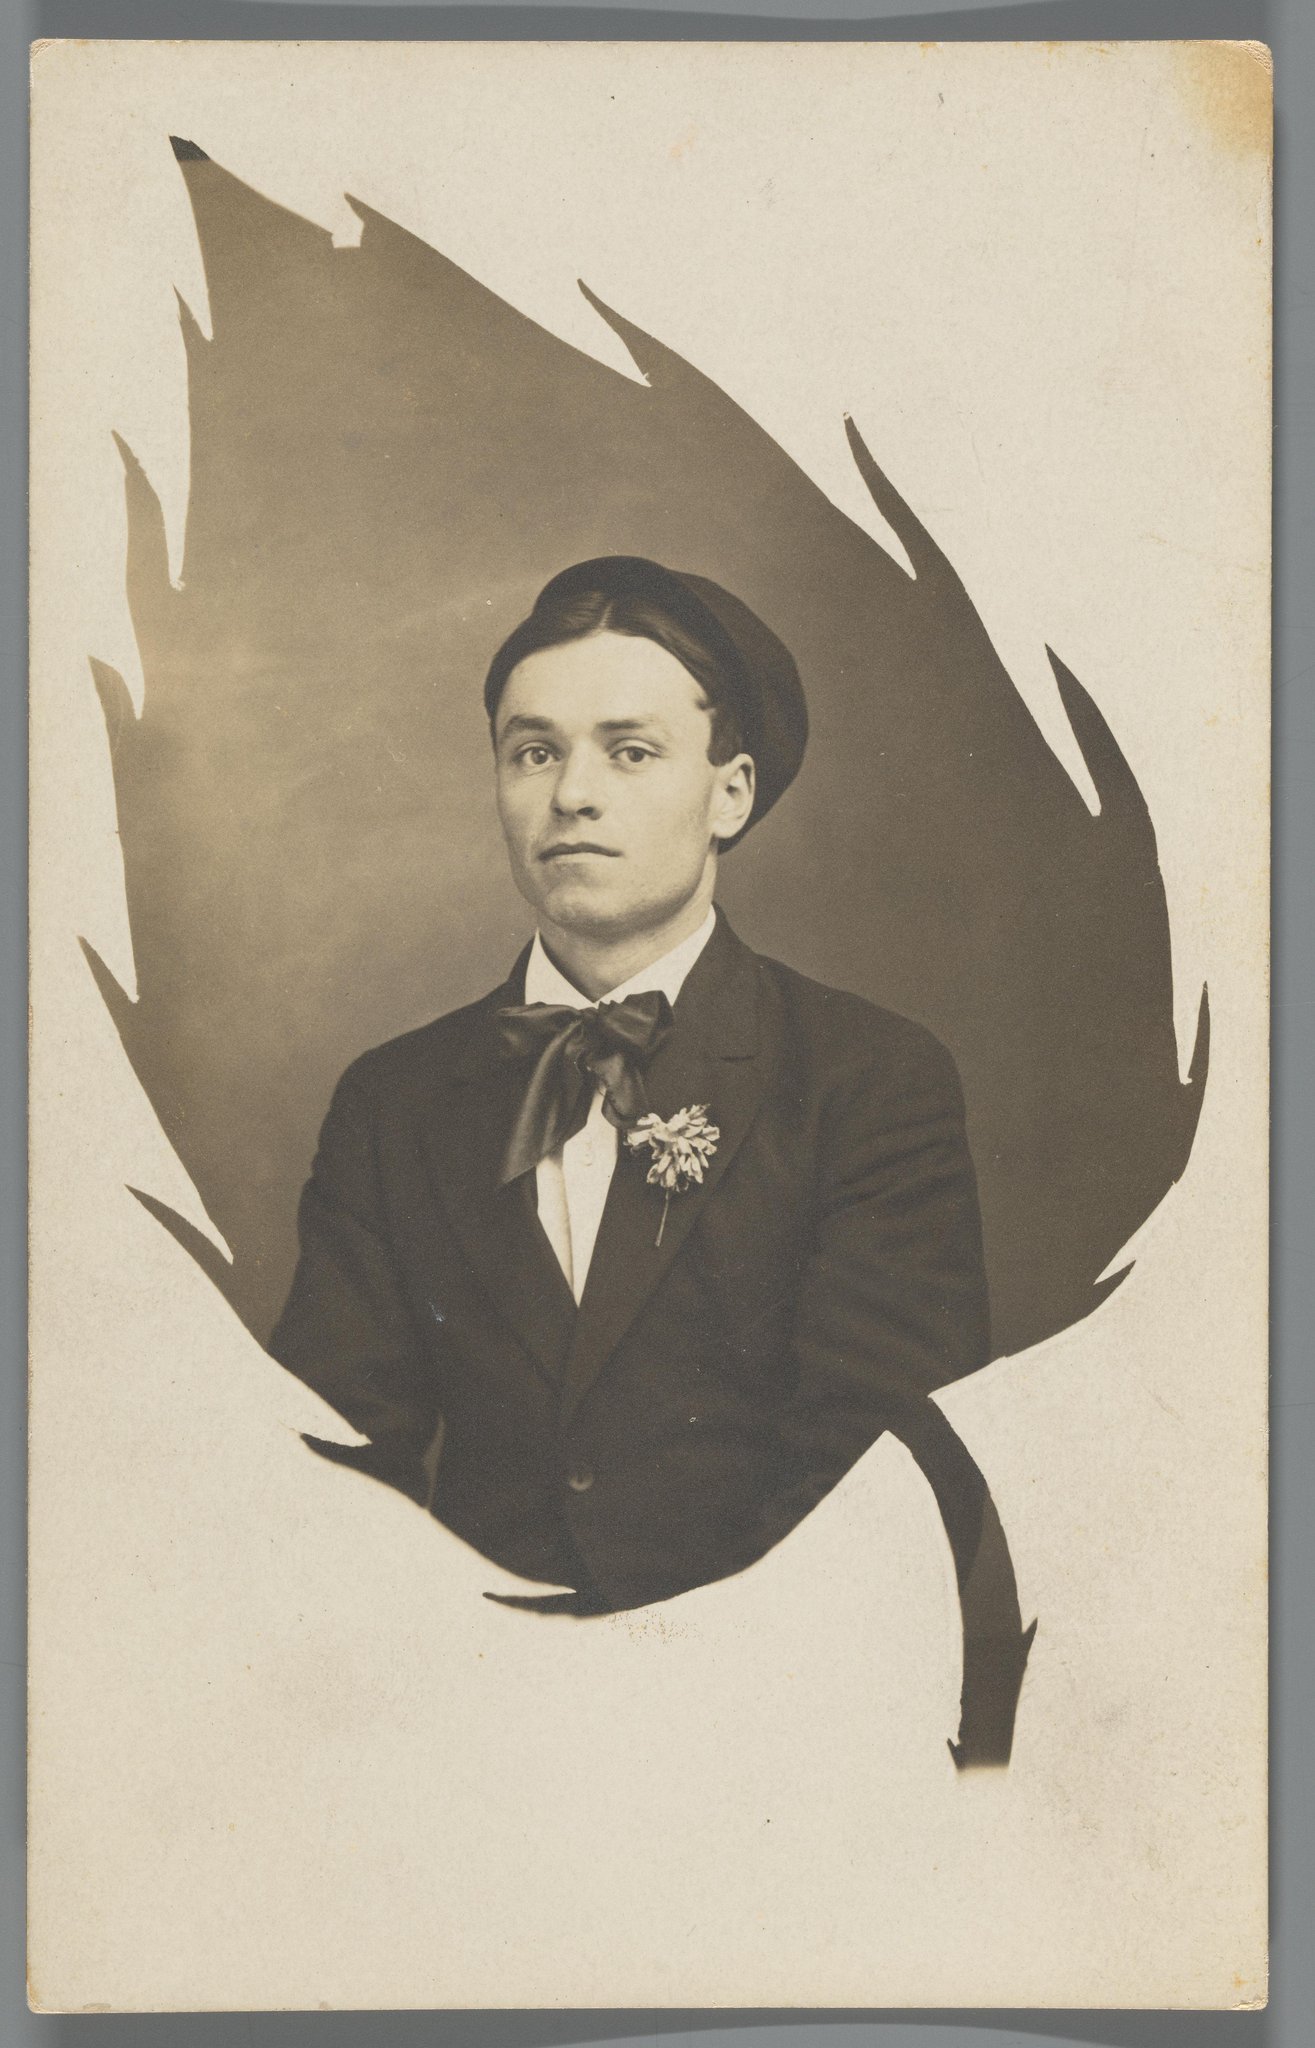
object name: cabinet photograph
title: Portret van jonge man, gevat in een contour van een boomblad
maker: Anonymous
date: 1920-1950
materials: photographic support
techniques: photography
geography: united states